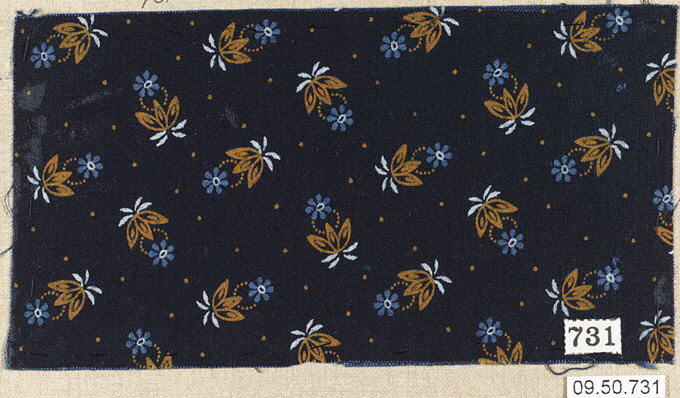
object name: piece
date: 1801-1900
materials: cotton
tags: leaves